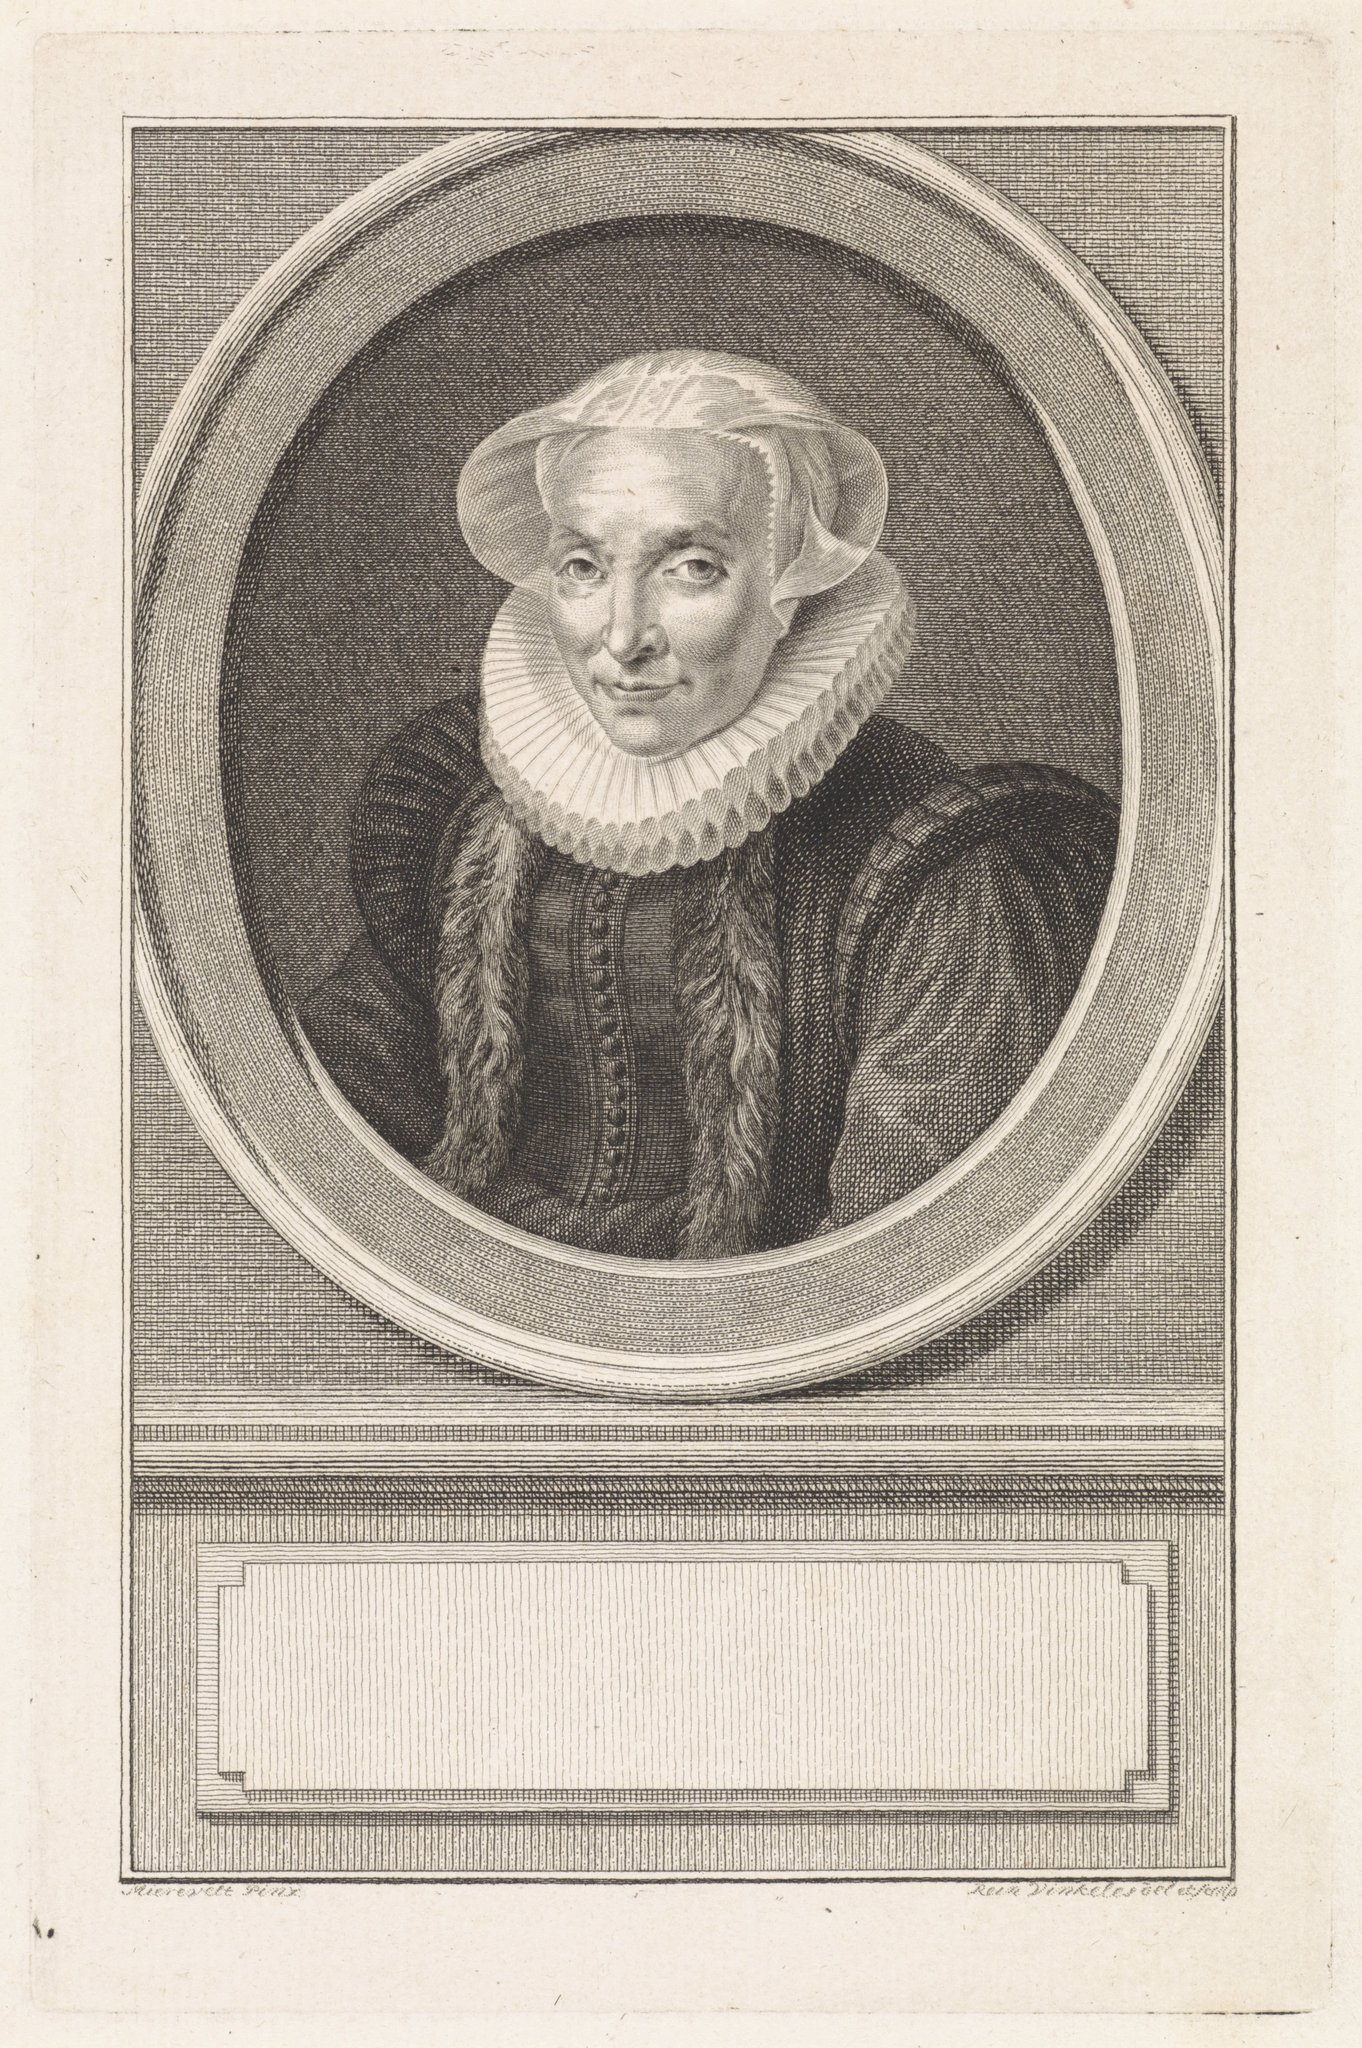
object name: print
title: Portret van Maria van Utrecht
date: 1751-1816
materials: paper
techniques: engraving, etching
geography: amsterdam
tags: maria van utrecht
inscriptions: collector's mark: Lugt 2228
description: Portret van Maria van Utrecht, echtgenote van Johan van Oldenbarnevelt, op 63-jarige leeftijd.